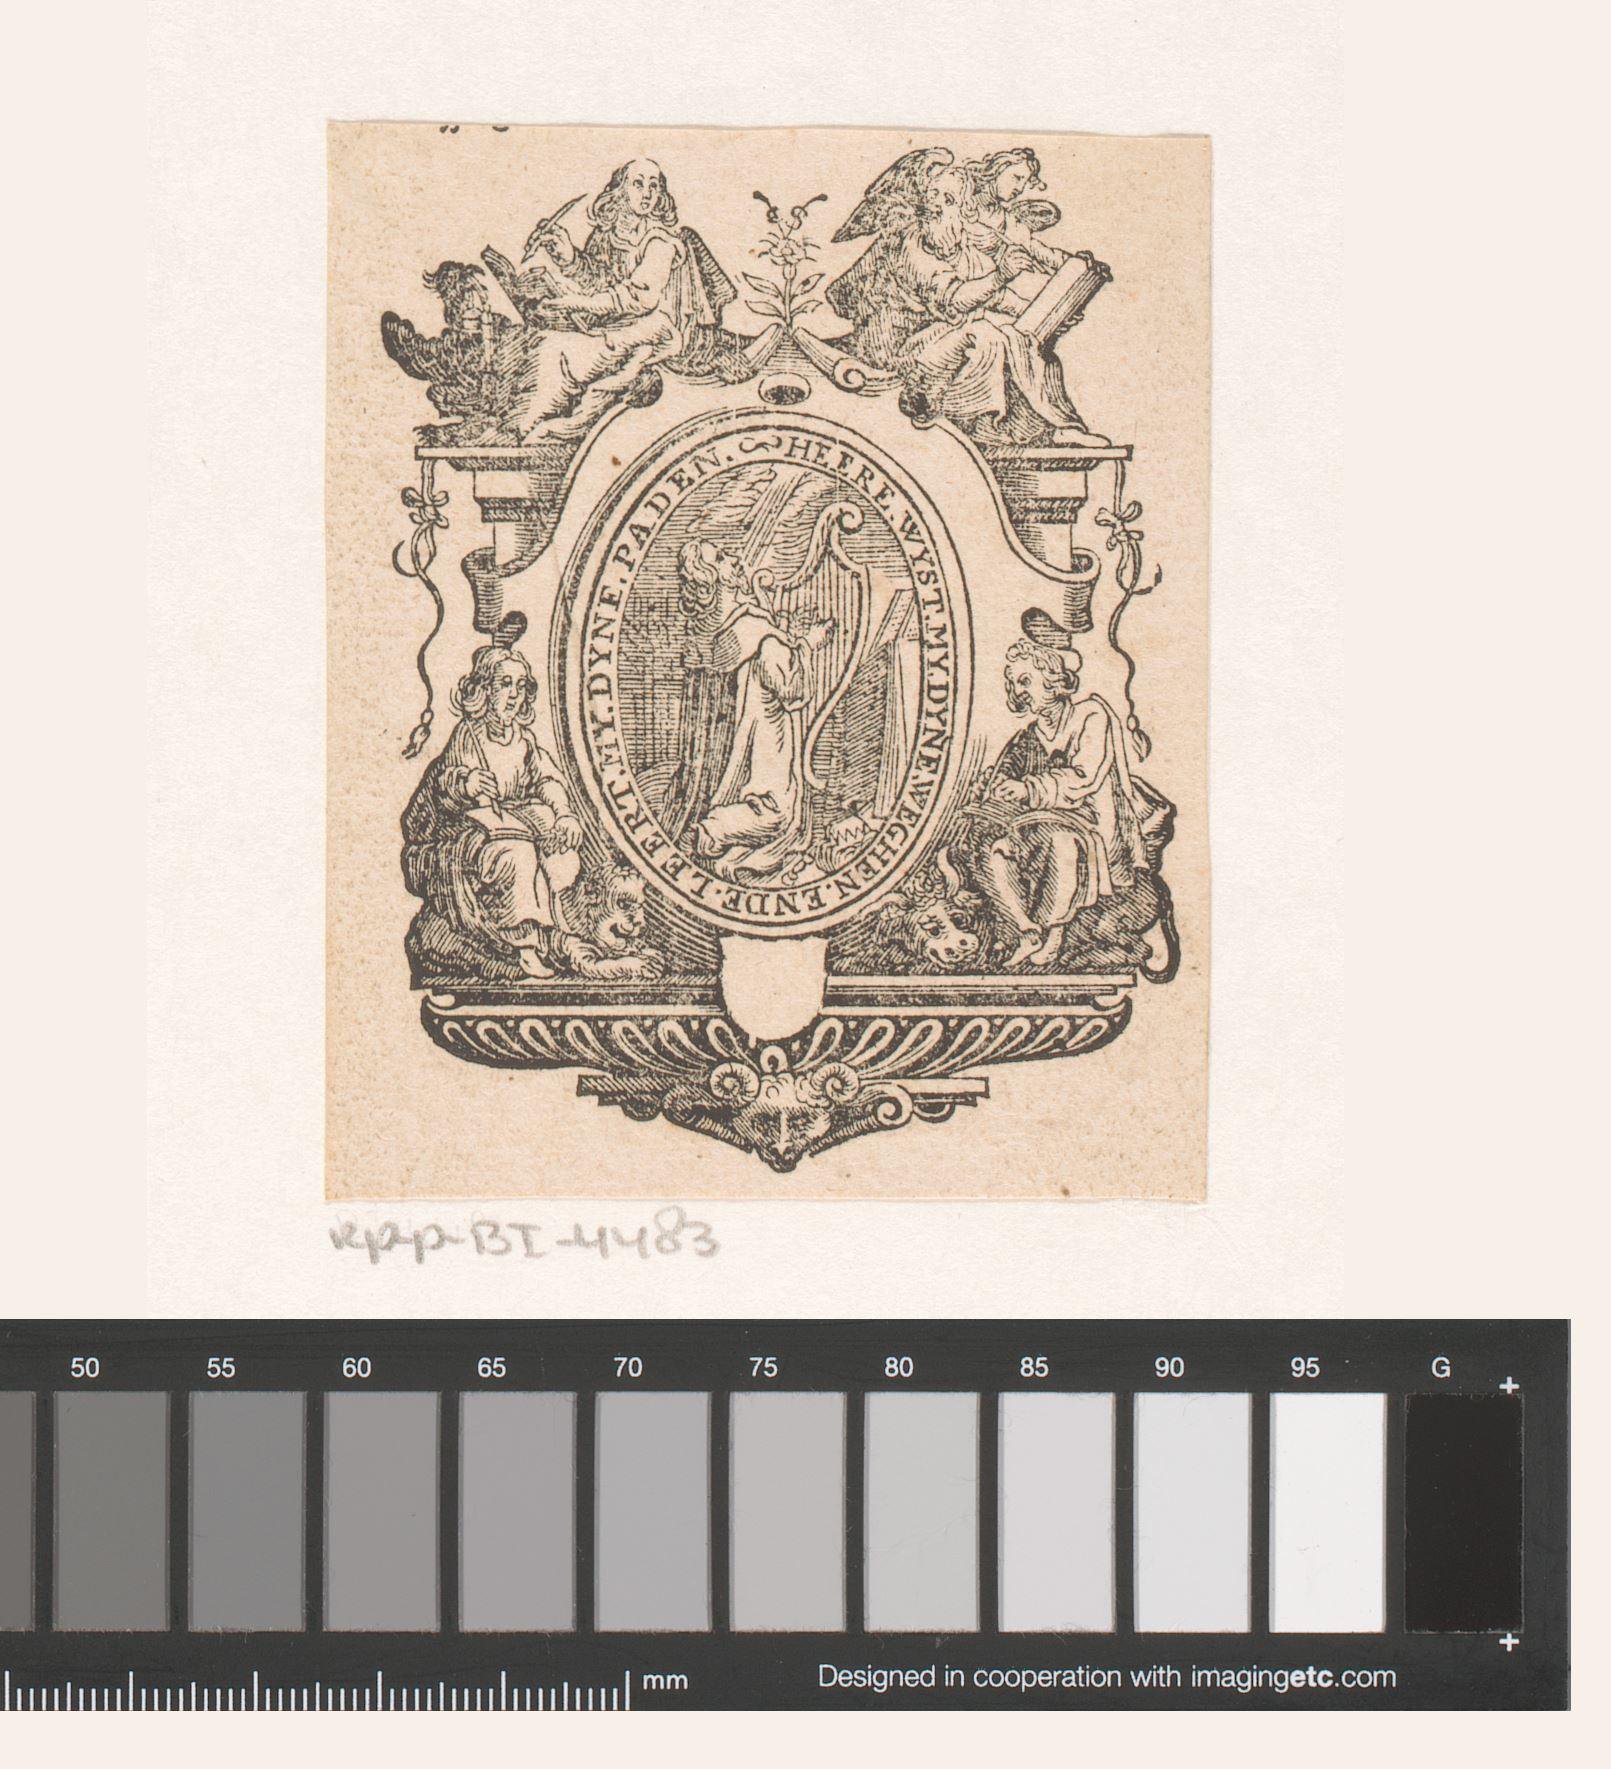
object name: print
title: Vignet met een harpspelende David en de vier evangelisten die hun evangelie schrijven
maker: Anonymous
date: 1600-1699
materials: paper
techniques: woodcut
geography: netherlands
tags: the apostle john the evangelist; possible attributes: book, cauldron, chalice with snake, eagle, palm, scroll, luke the evangelist; possible attributes: book, (winged) ox, portrait of the virgin, surgical instruments, painter's utensils, scroll, the apostle and evangelist matthew (mattheus); possible attributes: angel, axe, book, halberd, pen and inkhorn, purse, scroll, square, sword, david as musician, usually playing the harp, mark (marcus) the evangelist, and bishop of alexandria; possible attributes: book, (winged) lion, pen and inkhorn, scroll, vignette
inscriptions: collector's mark: Lugt 240